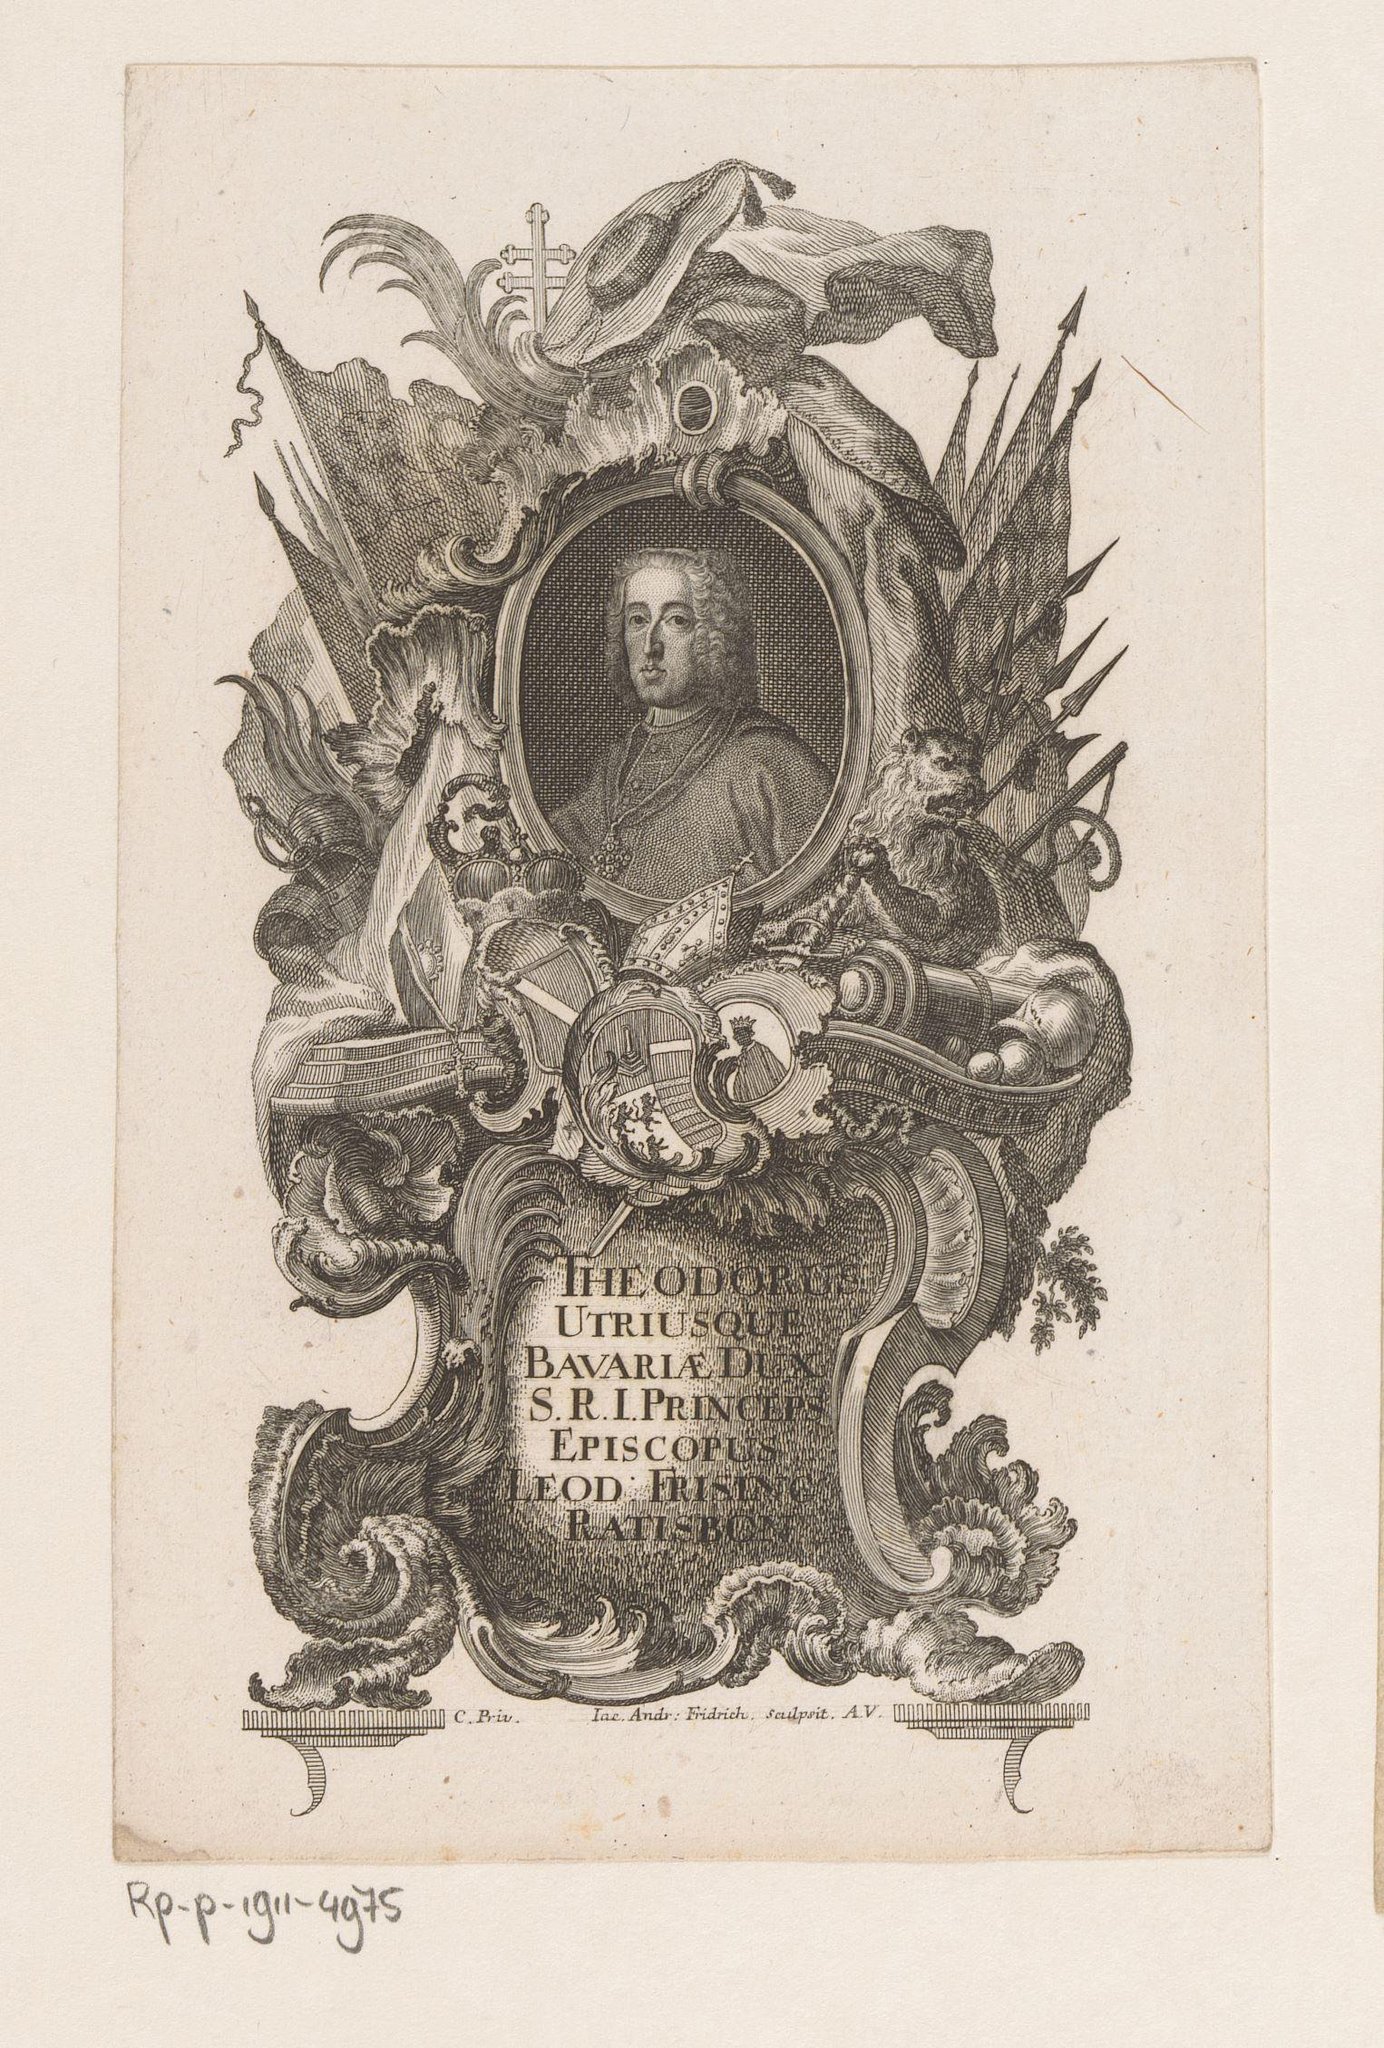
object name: print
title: Portret van Theodor von Regensburg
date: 1724-1763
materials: paper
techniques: engraving, etching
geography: holy roman empire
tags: rocaille ornament, insignia of bishop, e.g. mitre, crozier, ornament ~ medallion, historical persons, armorial bearing, heraldry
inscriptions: collector's mark: Lugt 2228